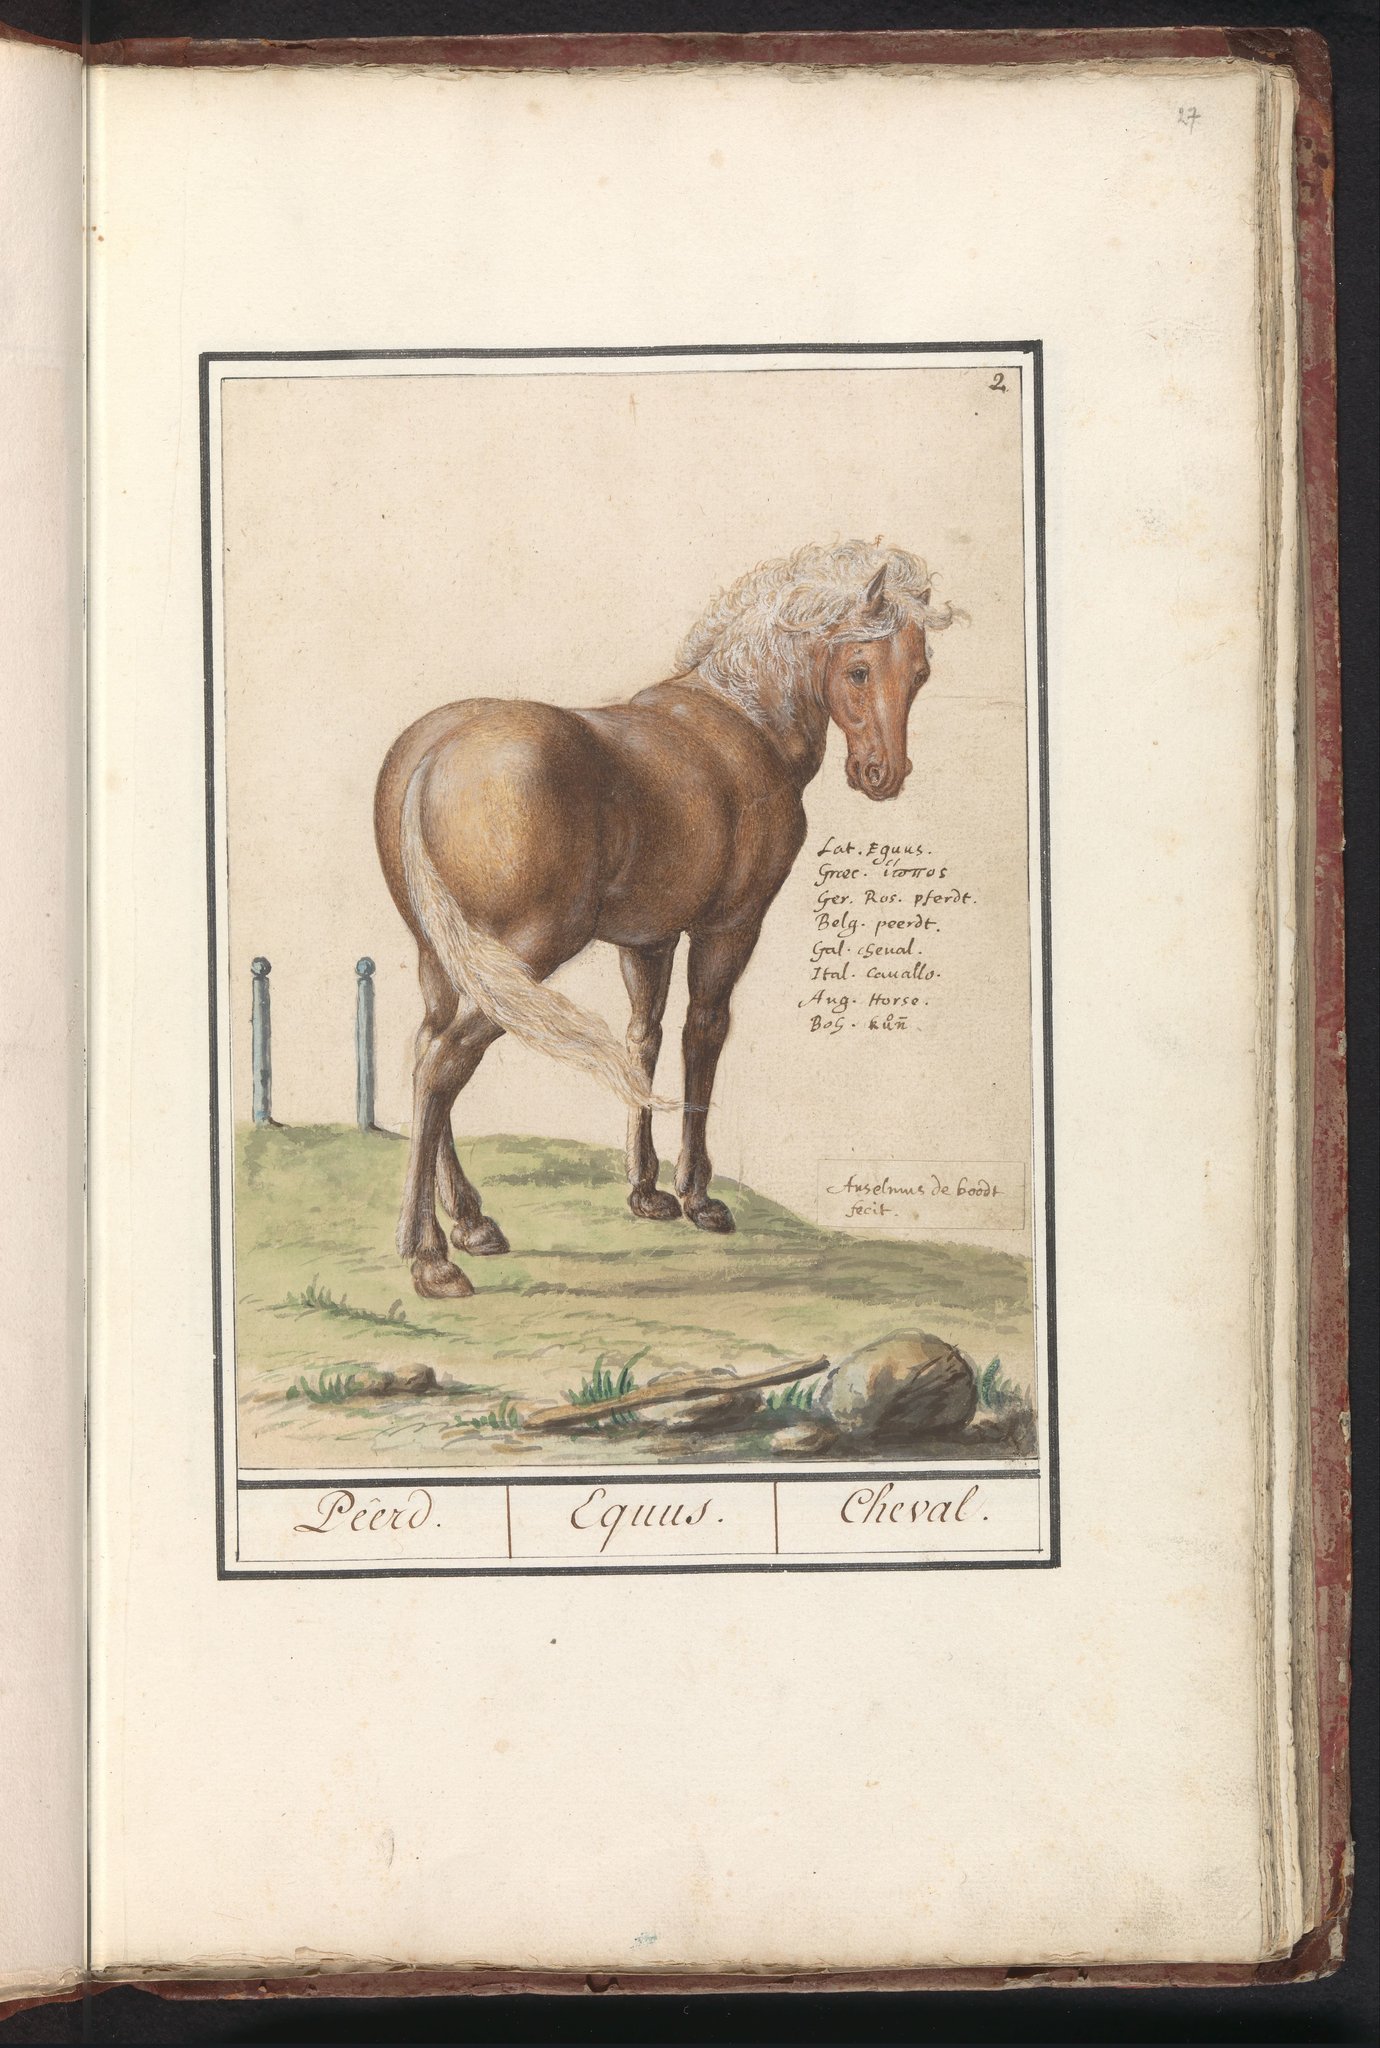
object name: drawing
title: Peerd. / Equus. / Cheval.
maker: anselmus boëtius de boodt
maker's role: draughtsman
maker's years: 1550-1632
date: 1596-1610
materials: paint, ink, paper, watercolor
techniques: brush, pen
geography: prague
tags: horse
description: Paard. Genummerd rechtsboven: 2. Rechtsmidden de naam in acht talen. Onderdeel van het eerste album met tekeningen van viervoeters. Eerste van twaalf albums met tekeningen van dieren, vogels en planten bekend rond 1600, gemaakt in opdracht van keizer Rudolf II. Met toelichting in Nederlands, Latijn en Frans.